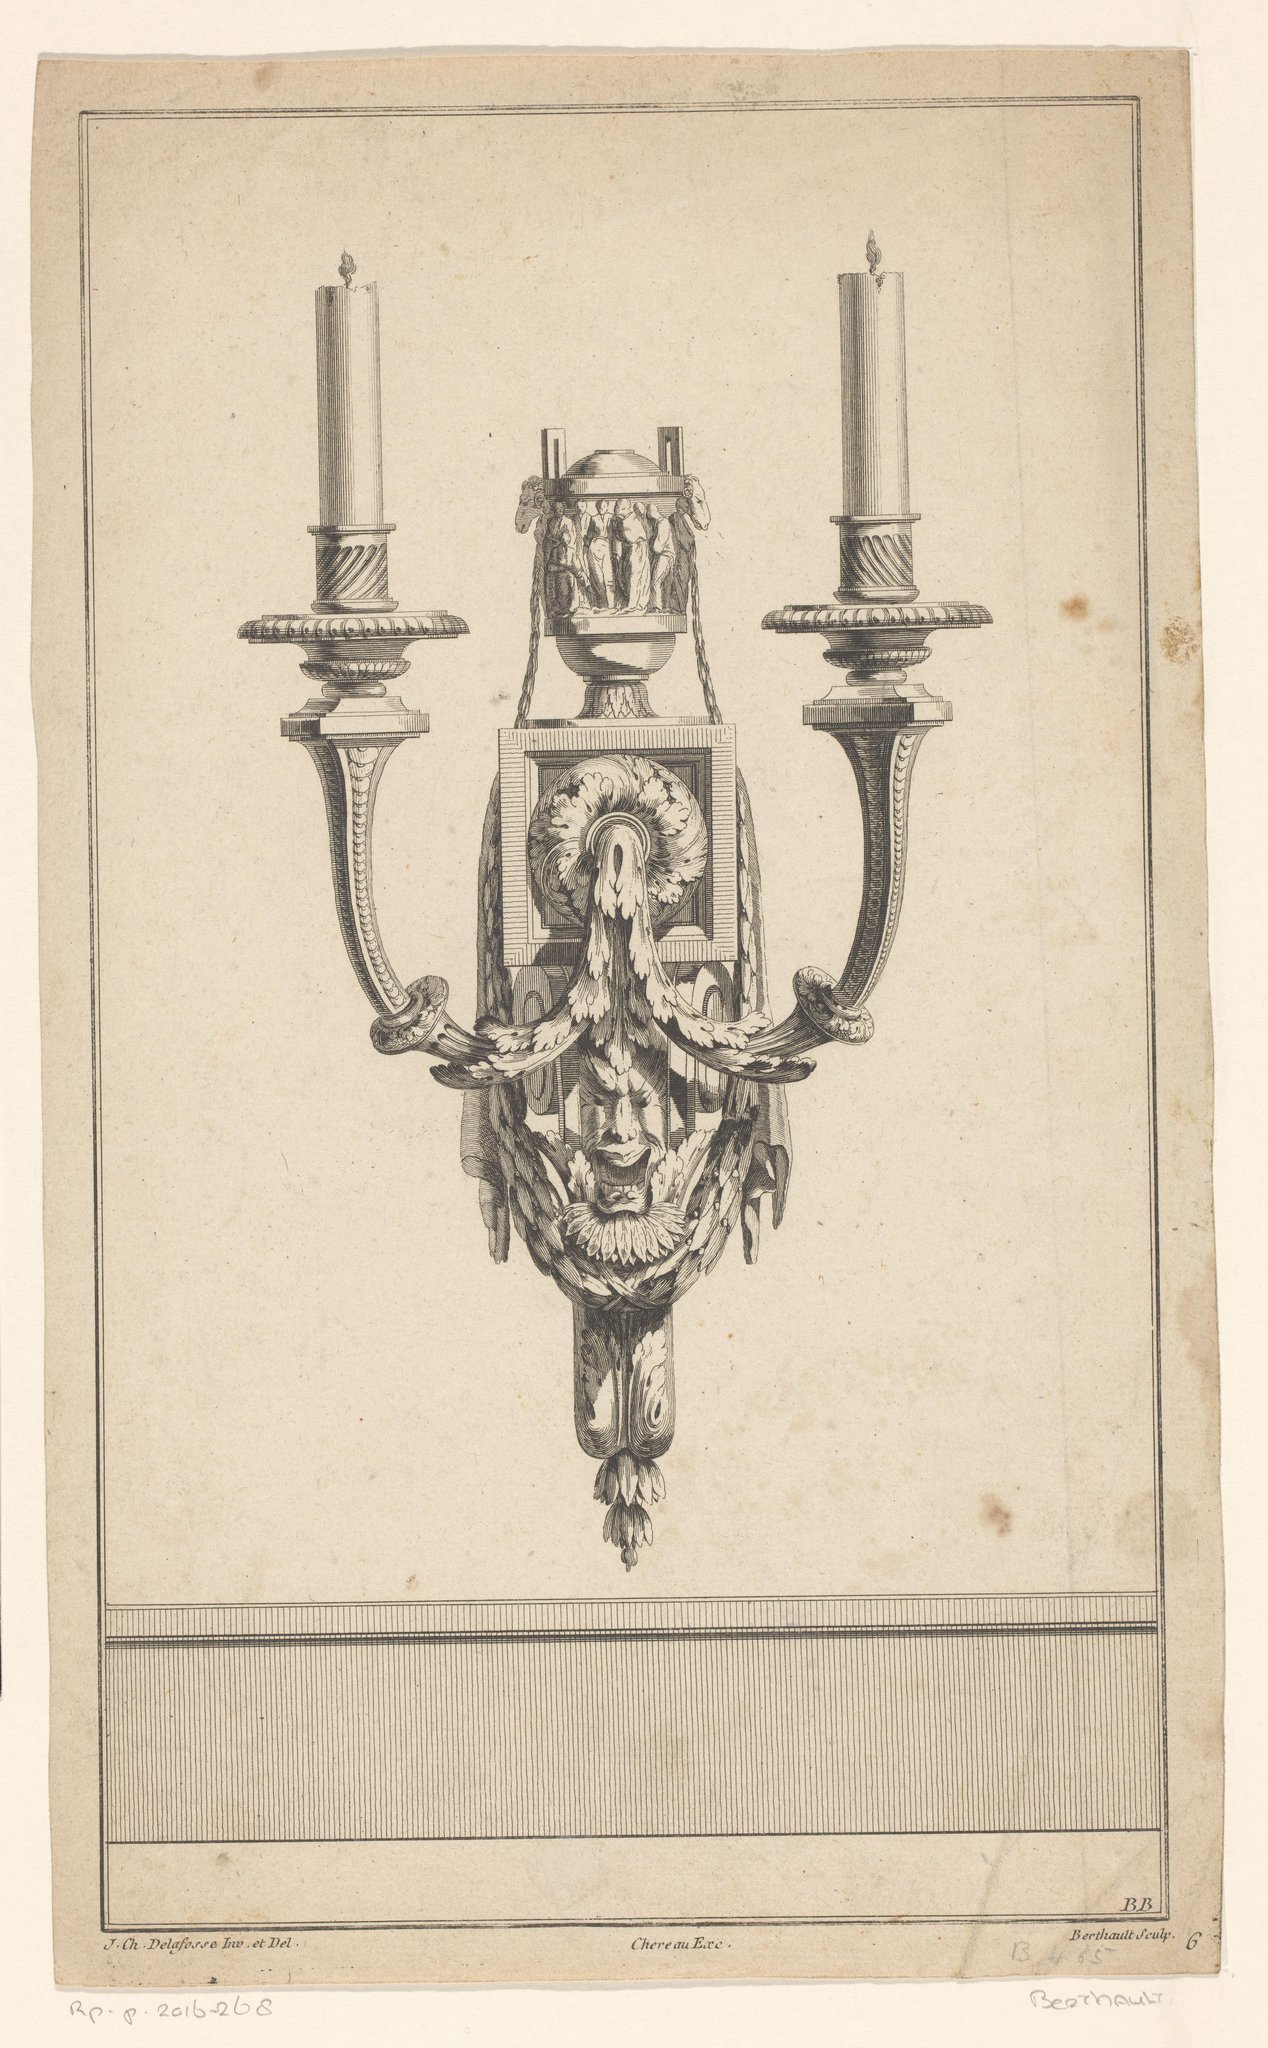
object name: print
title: Girandole met vaas en masker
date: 1771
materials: paper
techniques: engraving, etching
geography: paris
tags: chandelier, candelabrum, ornament ~ festoon, garland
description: Een geornamenteerde tweearmige girandole met een vaas met figuren, bladmotieven en een masker.